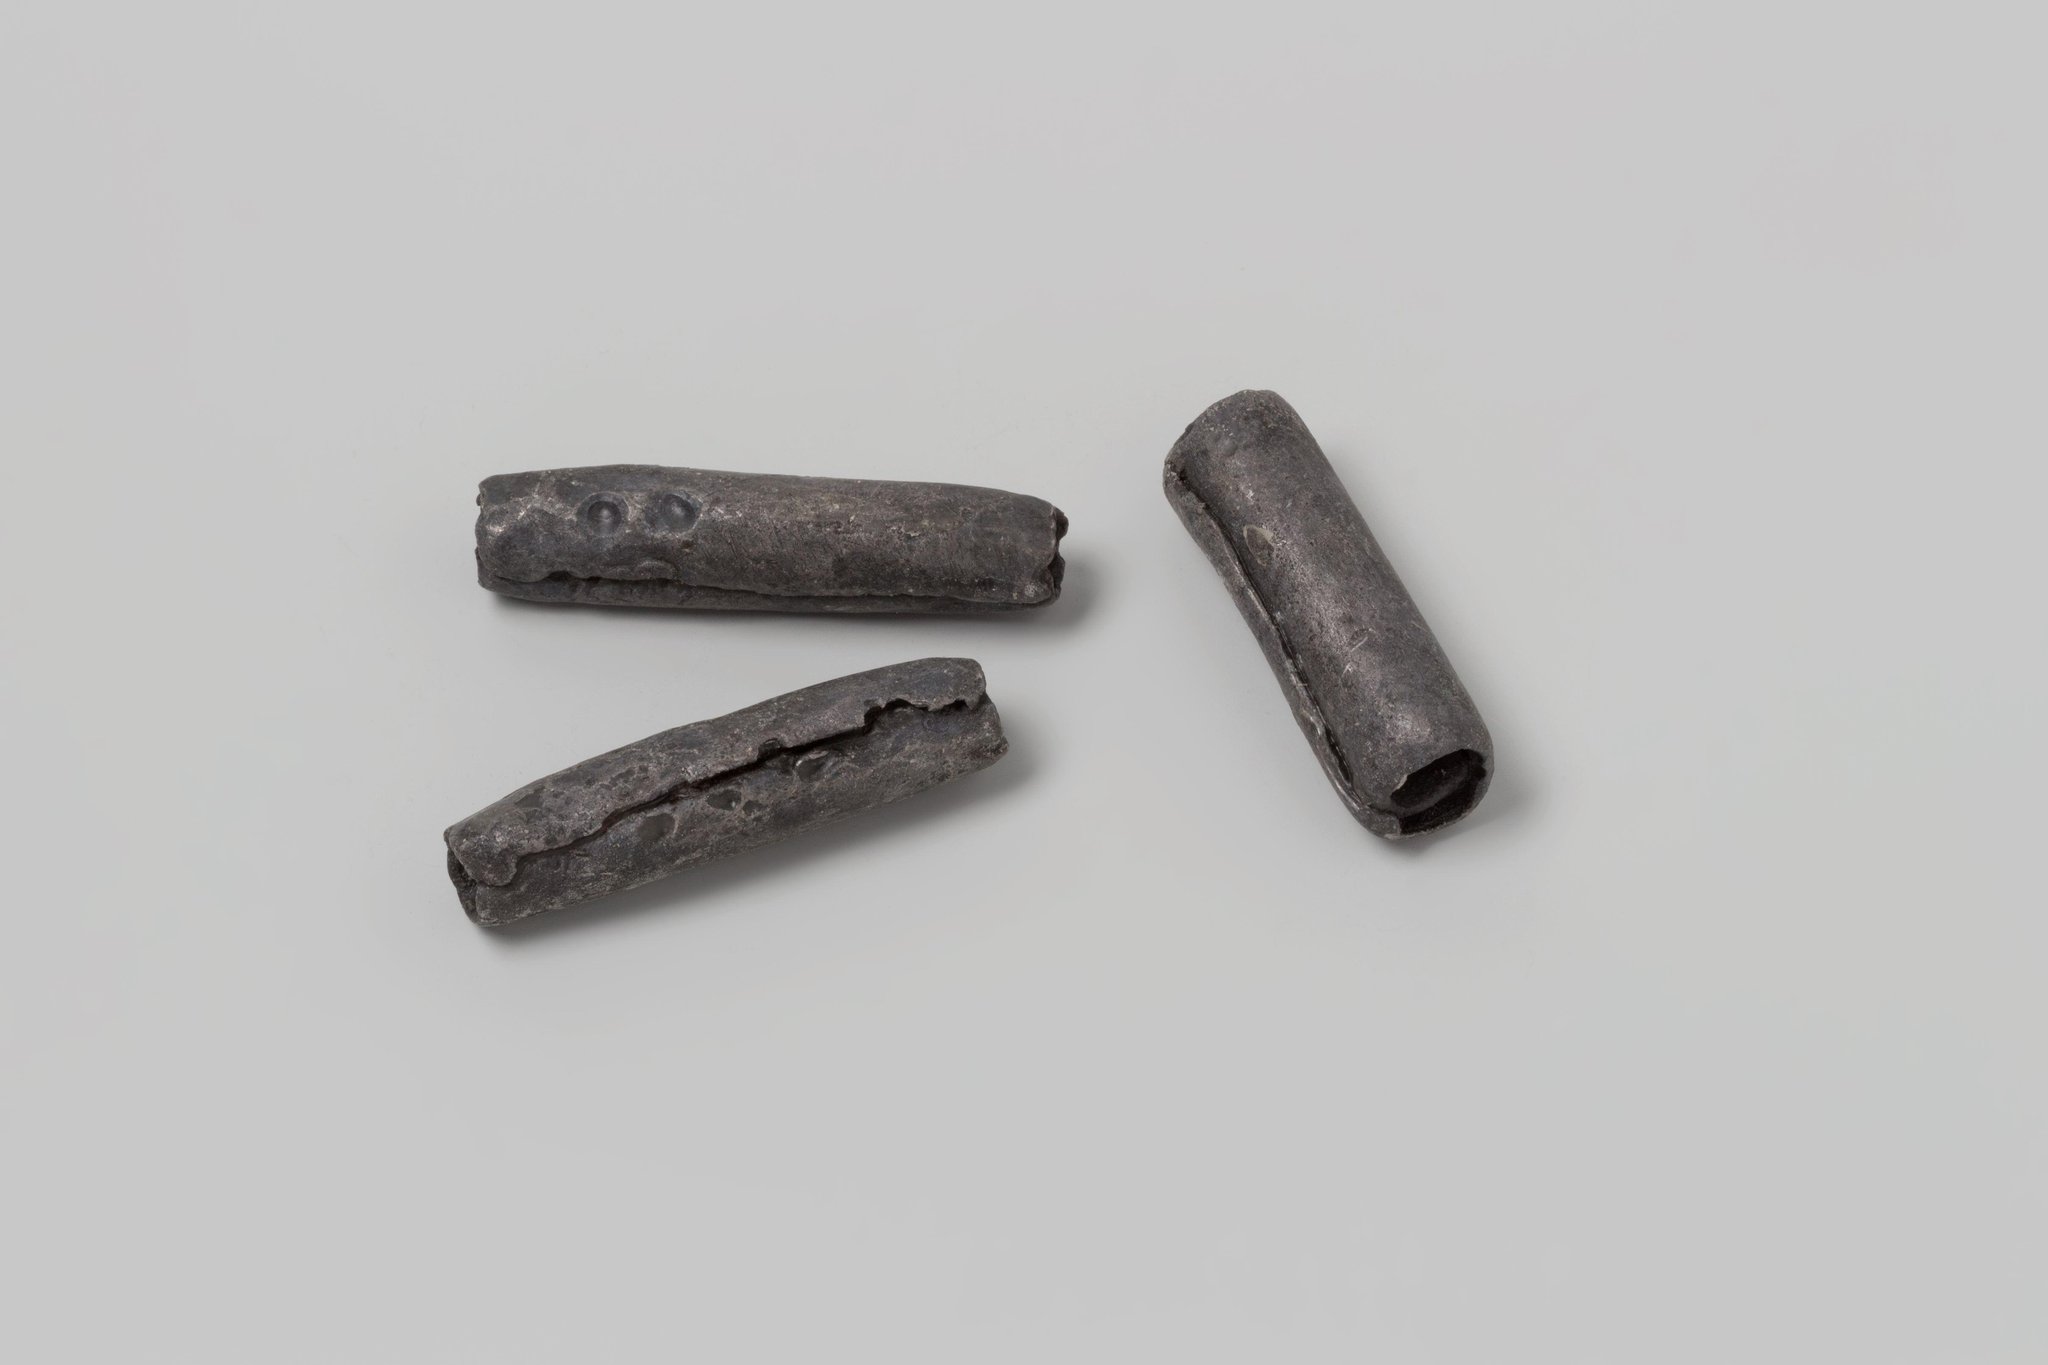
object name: lead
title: Loden rol uit het wrak van de Oost-Indiëvaarder 't Vliegend Hart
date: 1700-1735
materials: lead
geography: middelburg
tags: 't vliegend hart (schip), verenigde oostindische compagnie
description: Deze loden buisjes zijn vermoedelijk afkomstig van visnetten ofwel op TVliegend Hart zelf ofwel van vissers die hun netten aan het wrak verloren.